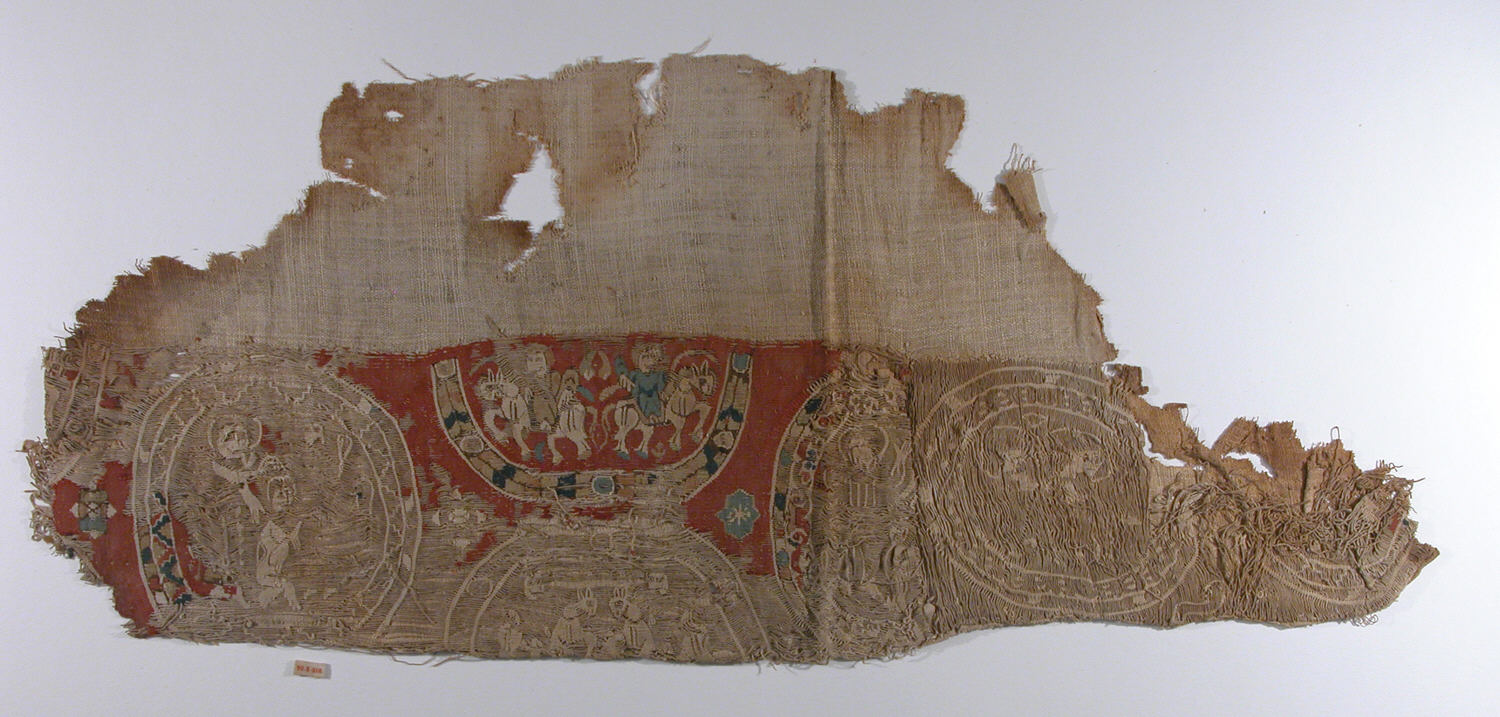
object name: textile fragment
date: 501-700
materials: linen, wool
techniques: weave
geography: egypt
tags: men,horses